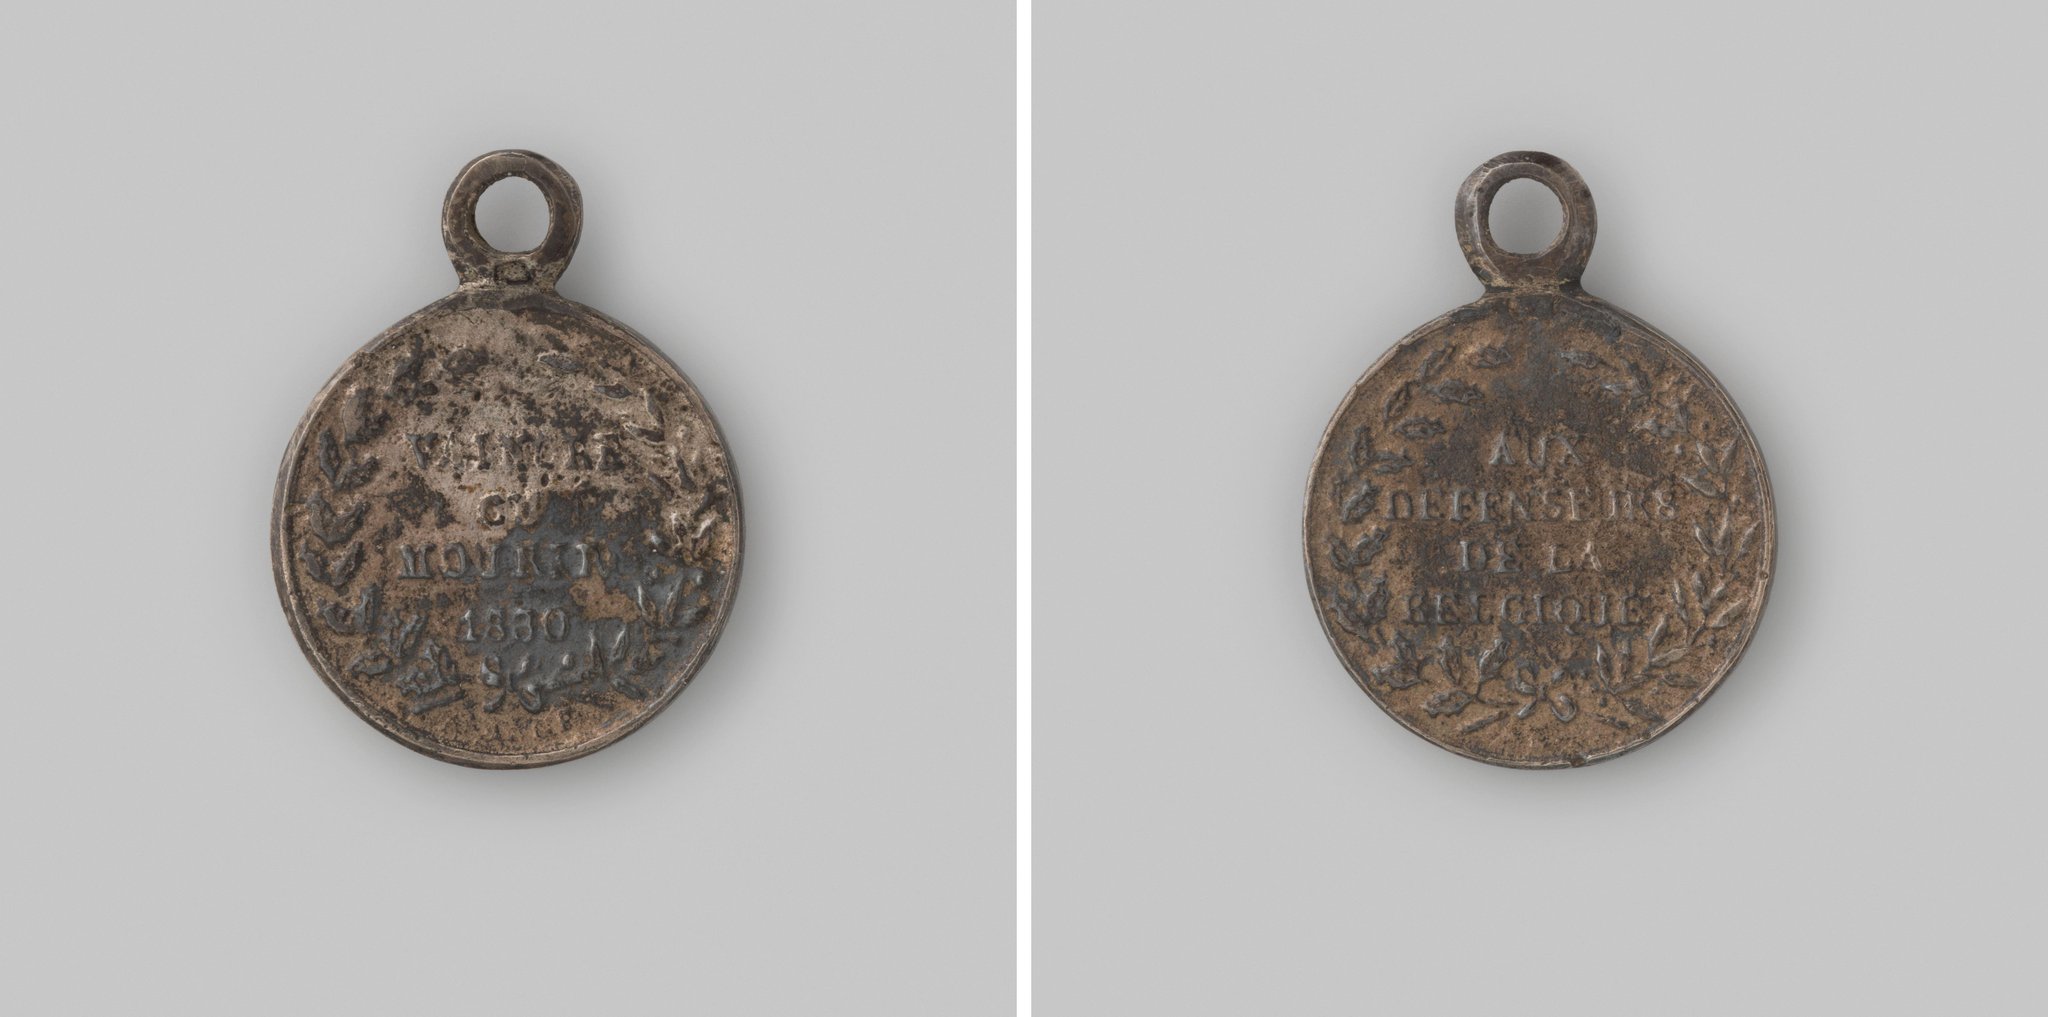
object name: history medal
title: Brusselse opstand 1830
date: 1830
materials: iron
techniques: casting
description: IJzeren penning met draagoog, op voor- en keerzijde vier regels tekst tussen samengestrikte lauwertakken.